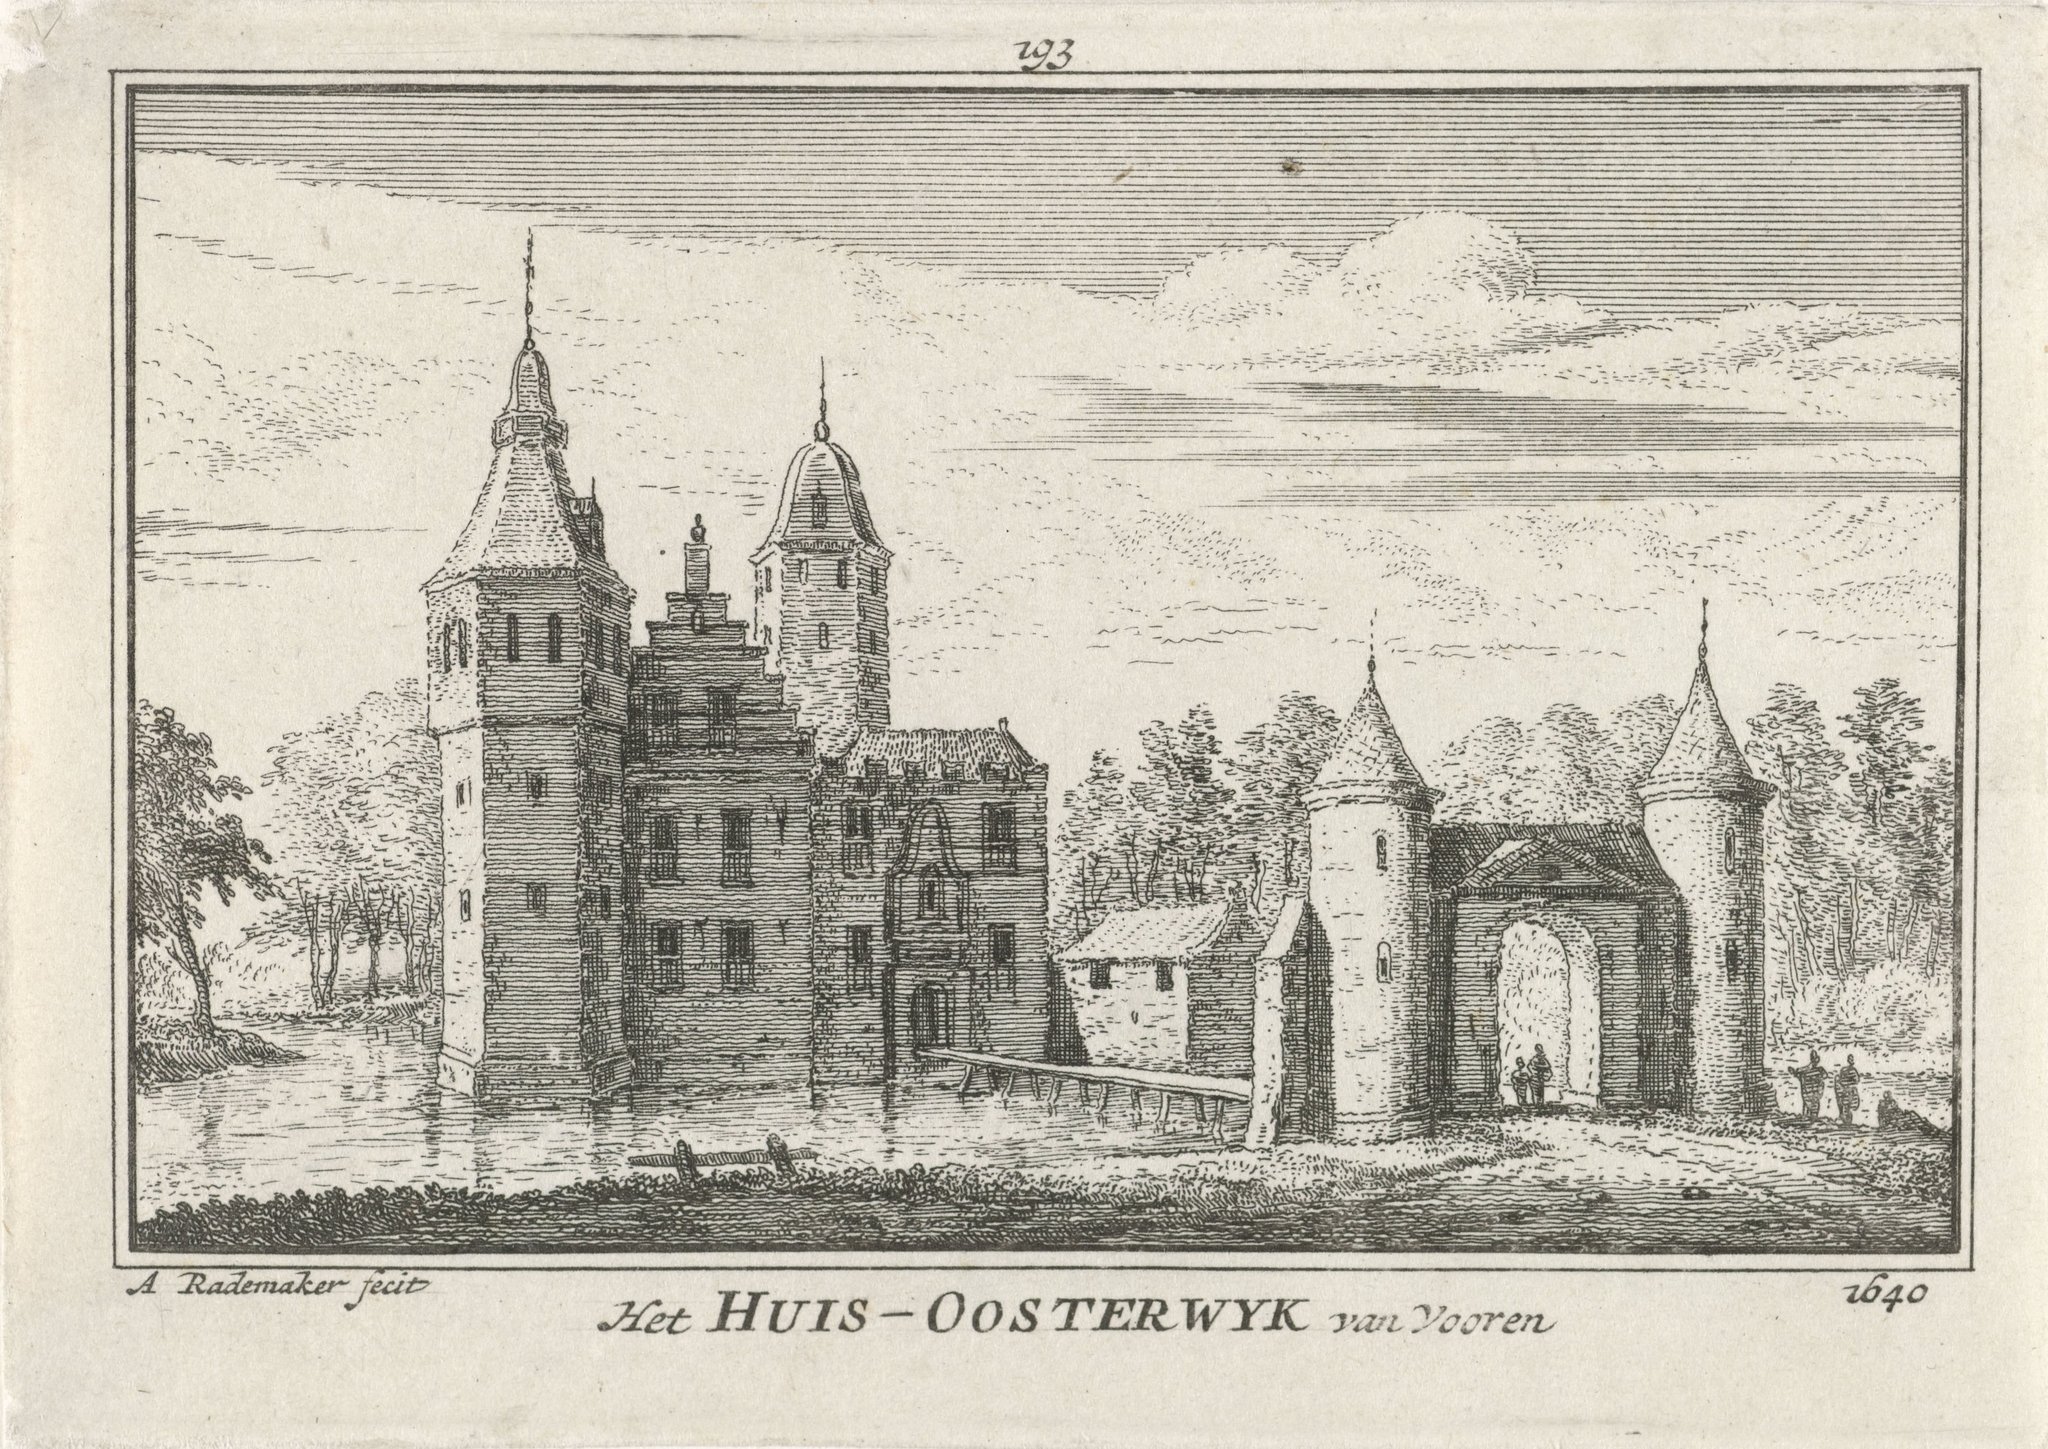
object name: print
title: Gezicht op Huis Oosterwijk, 1640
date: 1727-1733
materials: paper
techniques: etching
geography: amsterdam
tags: castle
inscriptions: collector's mark: Lugt 2228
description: Illustratie uit: Abraham Rademaker, Matthaeus Brouërius van Niedek, Isaac Le Long, Kabinet van Nederlandsche en Kleefsche outheden en (...) voorname stads- en landgebouwen, Willem Barents en Antoni Schoonenburg: Amsterdam, 1727-1733, ill. nr. 193.